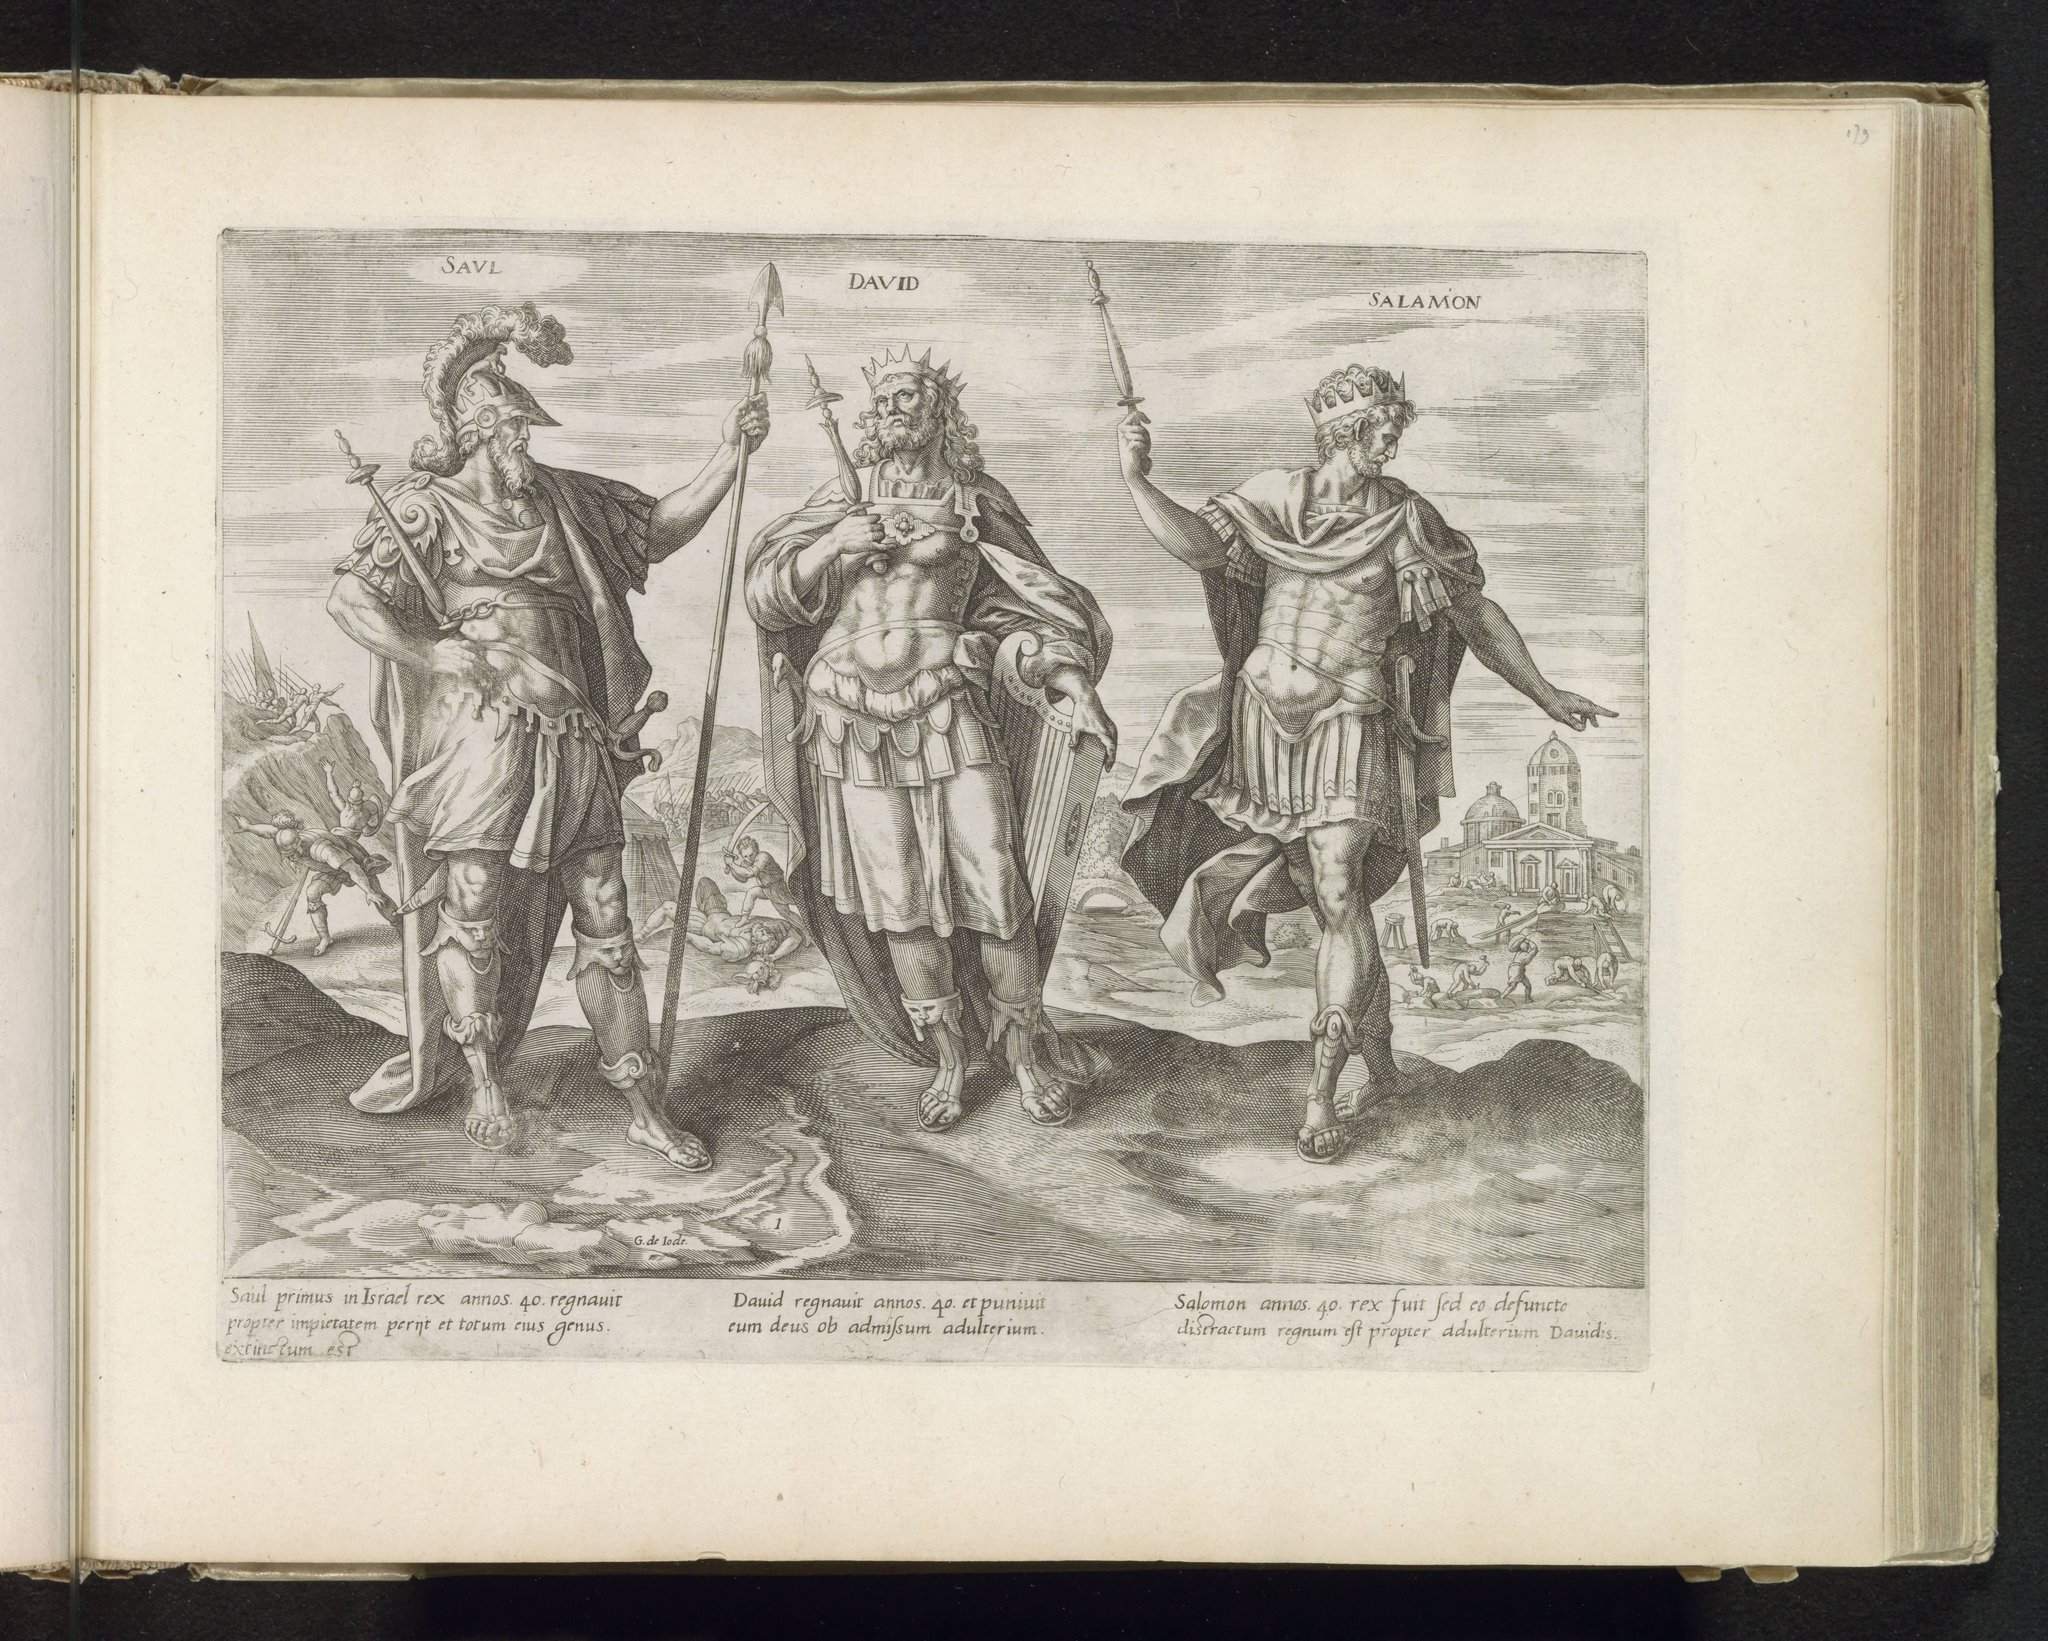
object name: album leaf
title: Thesaurus sacrarum historiaru[m] veteris testame[n]ti, elega[n]tissimis imaginibus expressu[m] excelle[n]tissimoru[m] in hac arte viroru[m] opera: nu[n]c primu[m] in luce[m] editus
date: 1585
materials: paper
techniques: engraving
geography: antwerp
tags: the construction of the temple of solomon, male persons from the old testament (with name) (not in biblical context), david (not in biblical context); possible attributes: crown, harp, david beheads goliath with a sword, solomon (not in biblical context); possible attributes of solomon: crown, sceptre, sword, saul kills himself with a sword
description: De koningen Saul, met speer in de hand, David, met harp in de hand en Salomo. Op de achtergrond belangrijke gebeurtenissen uit hun leven. Links de dood van Saul: hij stort zich in zijn eigen zwaard. Achter David is te zien hoe hij Goliat onthoofdt. Salomo wijst op de bouw van de tempel. Onder de voorstelling toelichtingen in het Latijn. Deze prent maakt deel uit van een album.